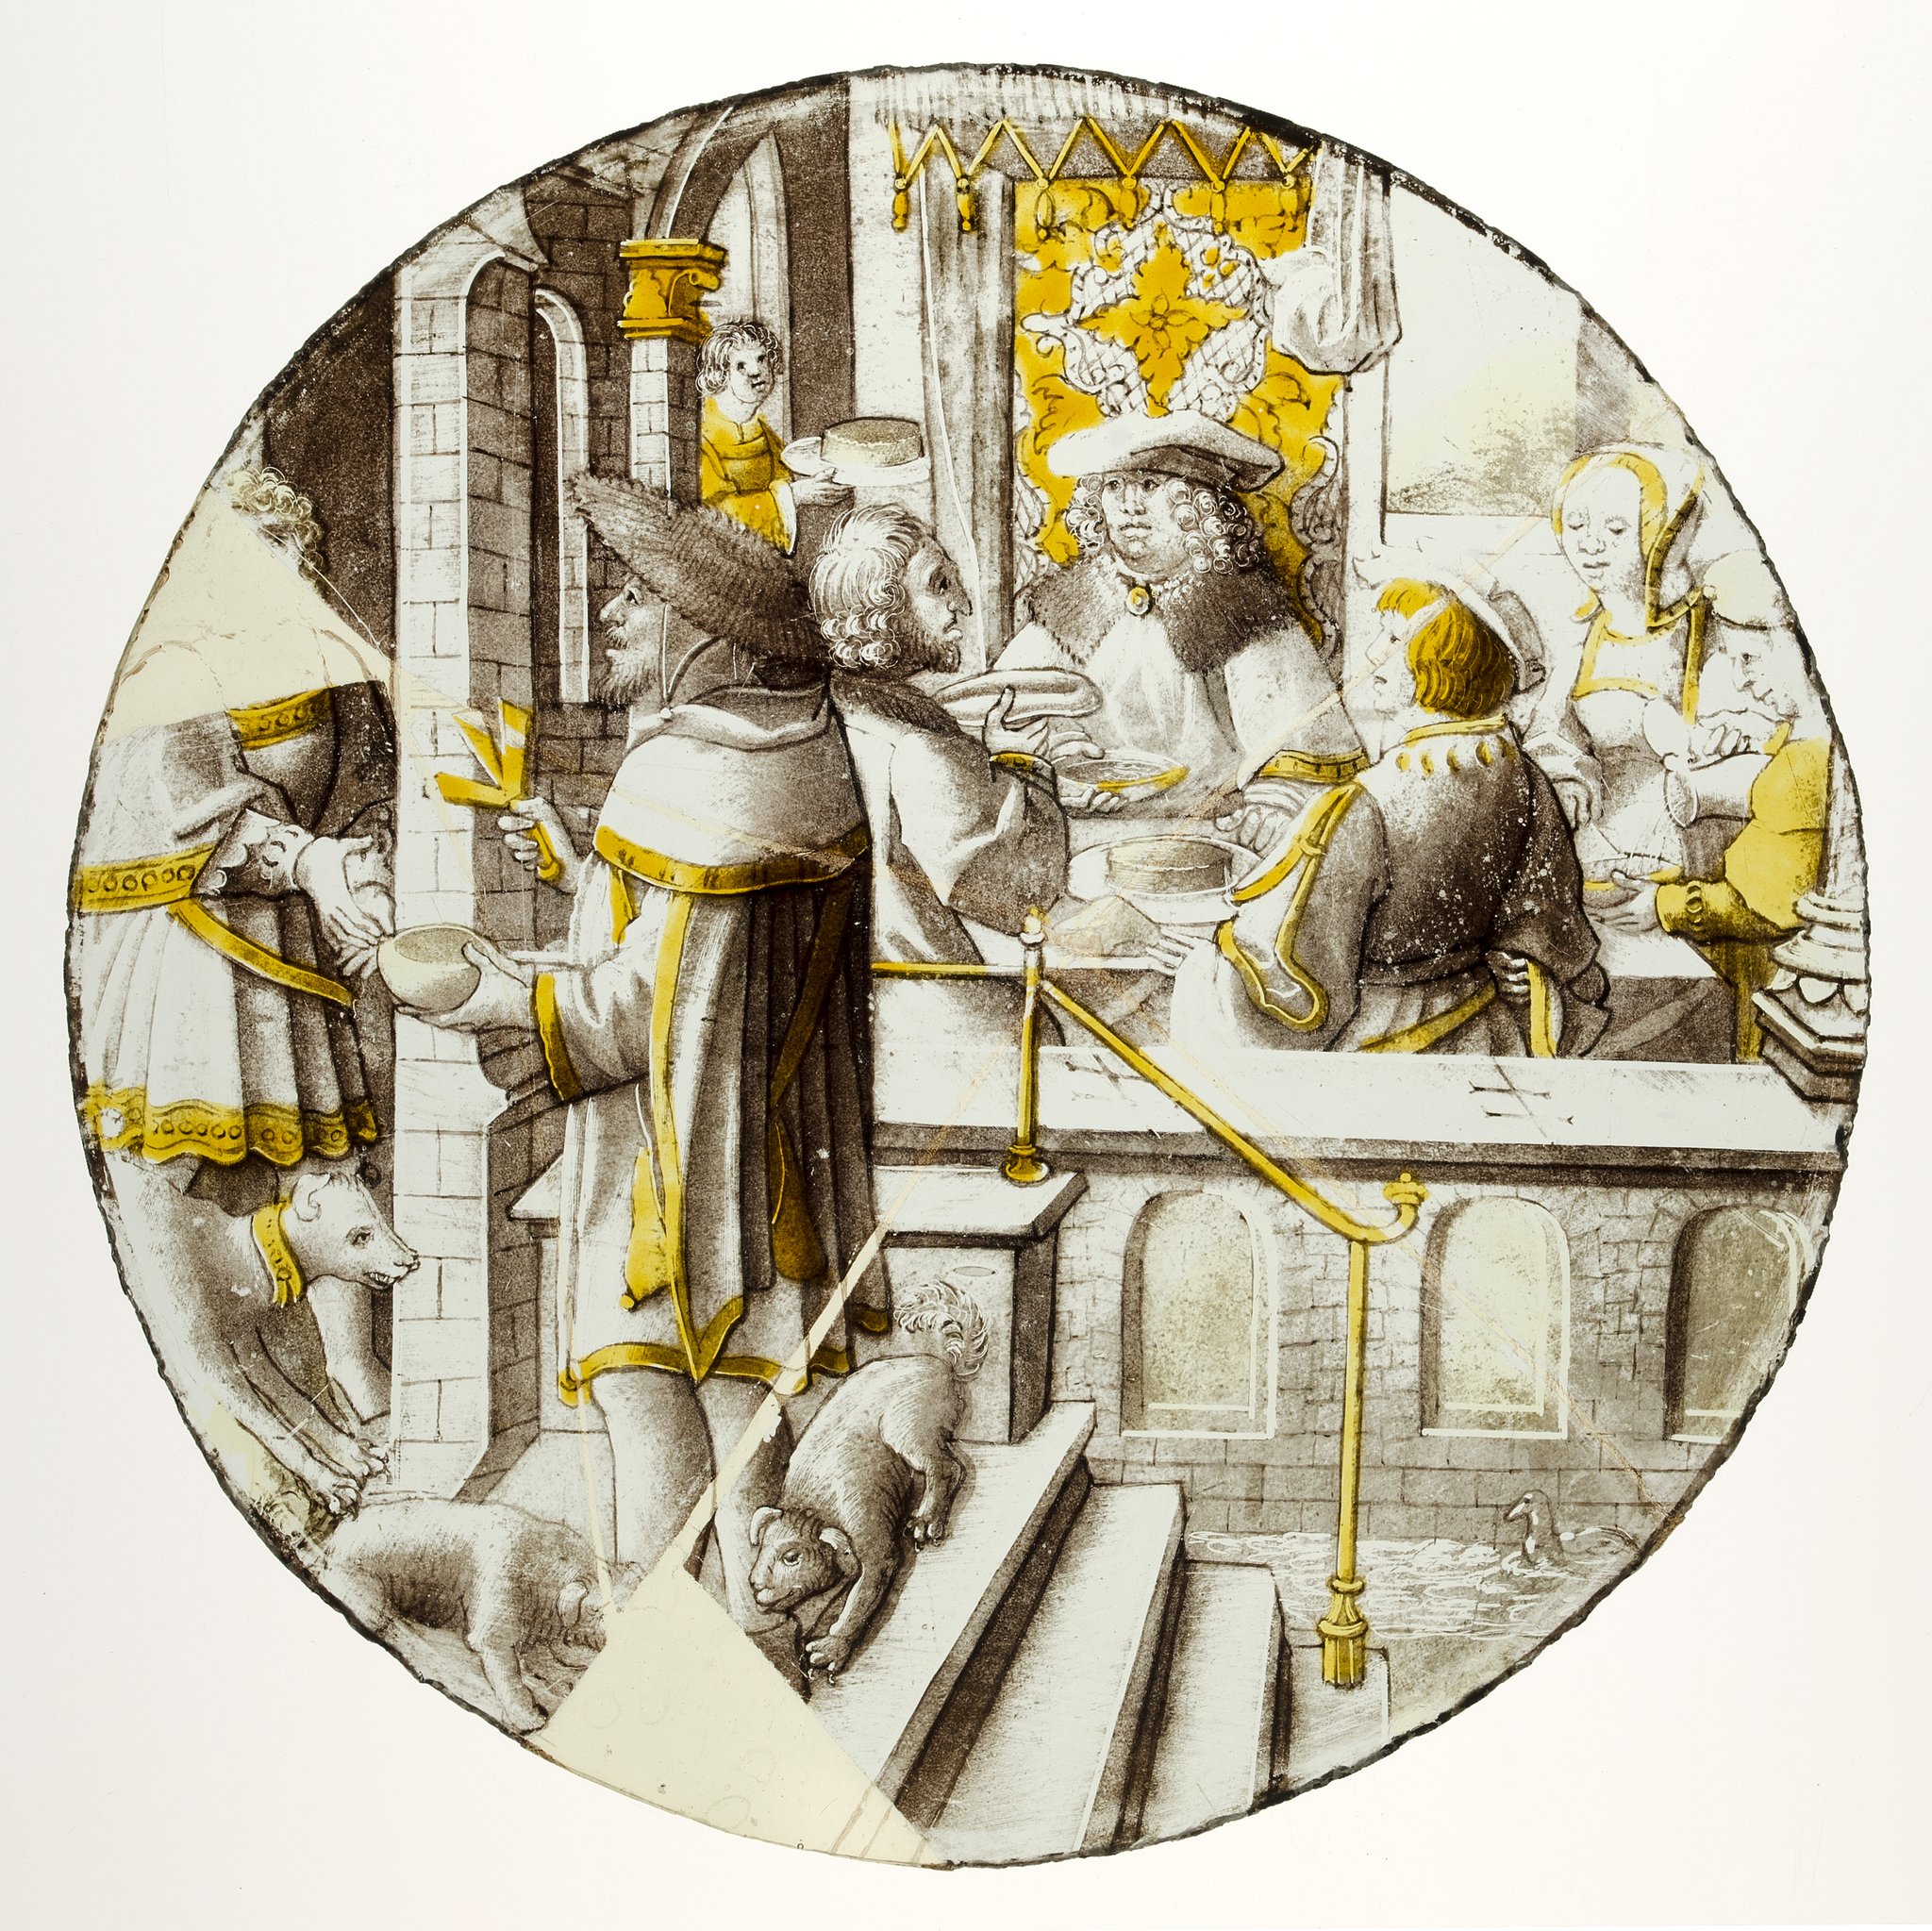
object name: roundel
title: Roundel with Lazarus at the House of Dives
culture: dutch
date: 1510-1520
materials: glass, paint, pigment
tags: food,men,women,dogs,dining